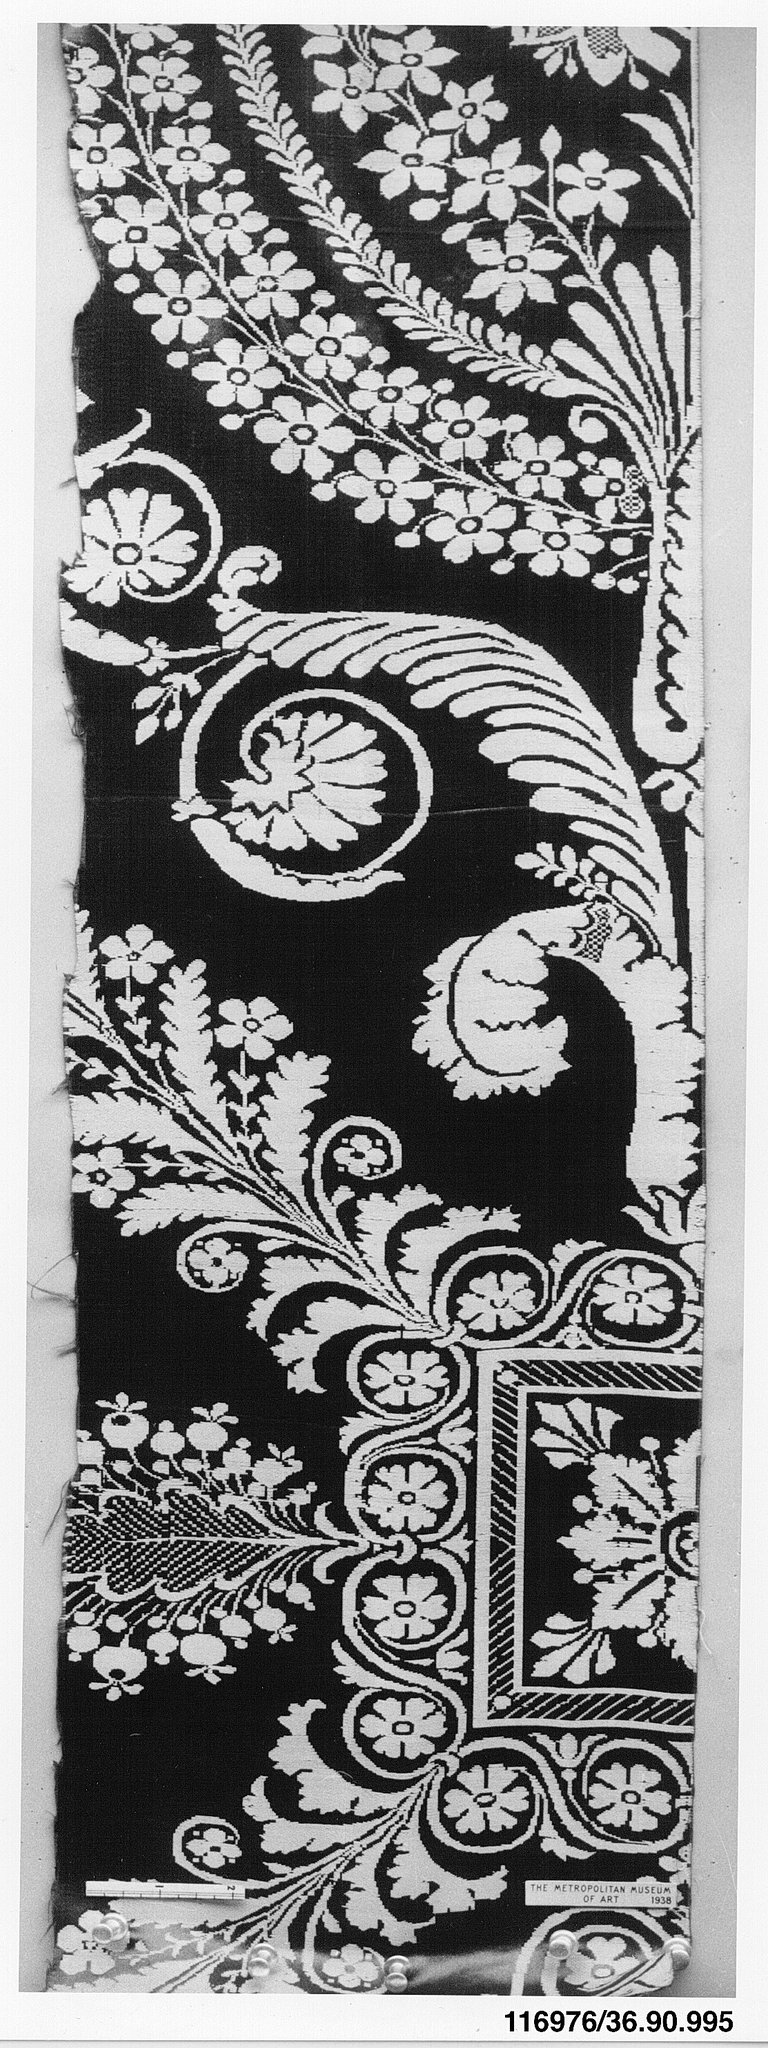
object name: piece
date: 1801-1900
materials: silk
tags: flowers,leaves